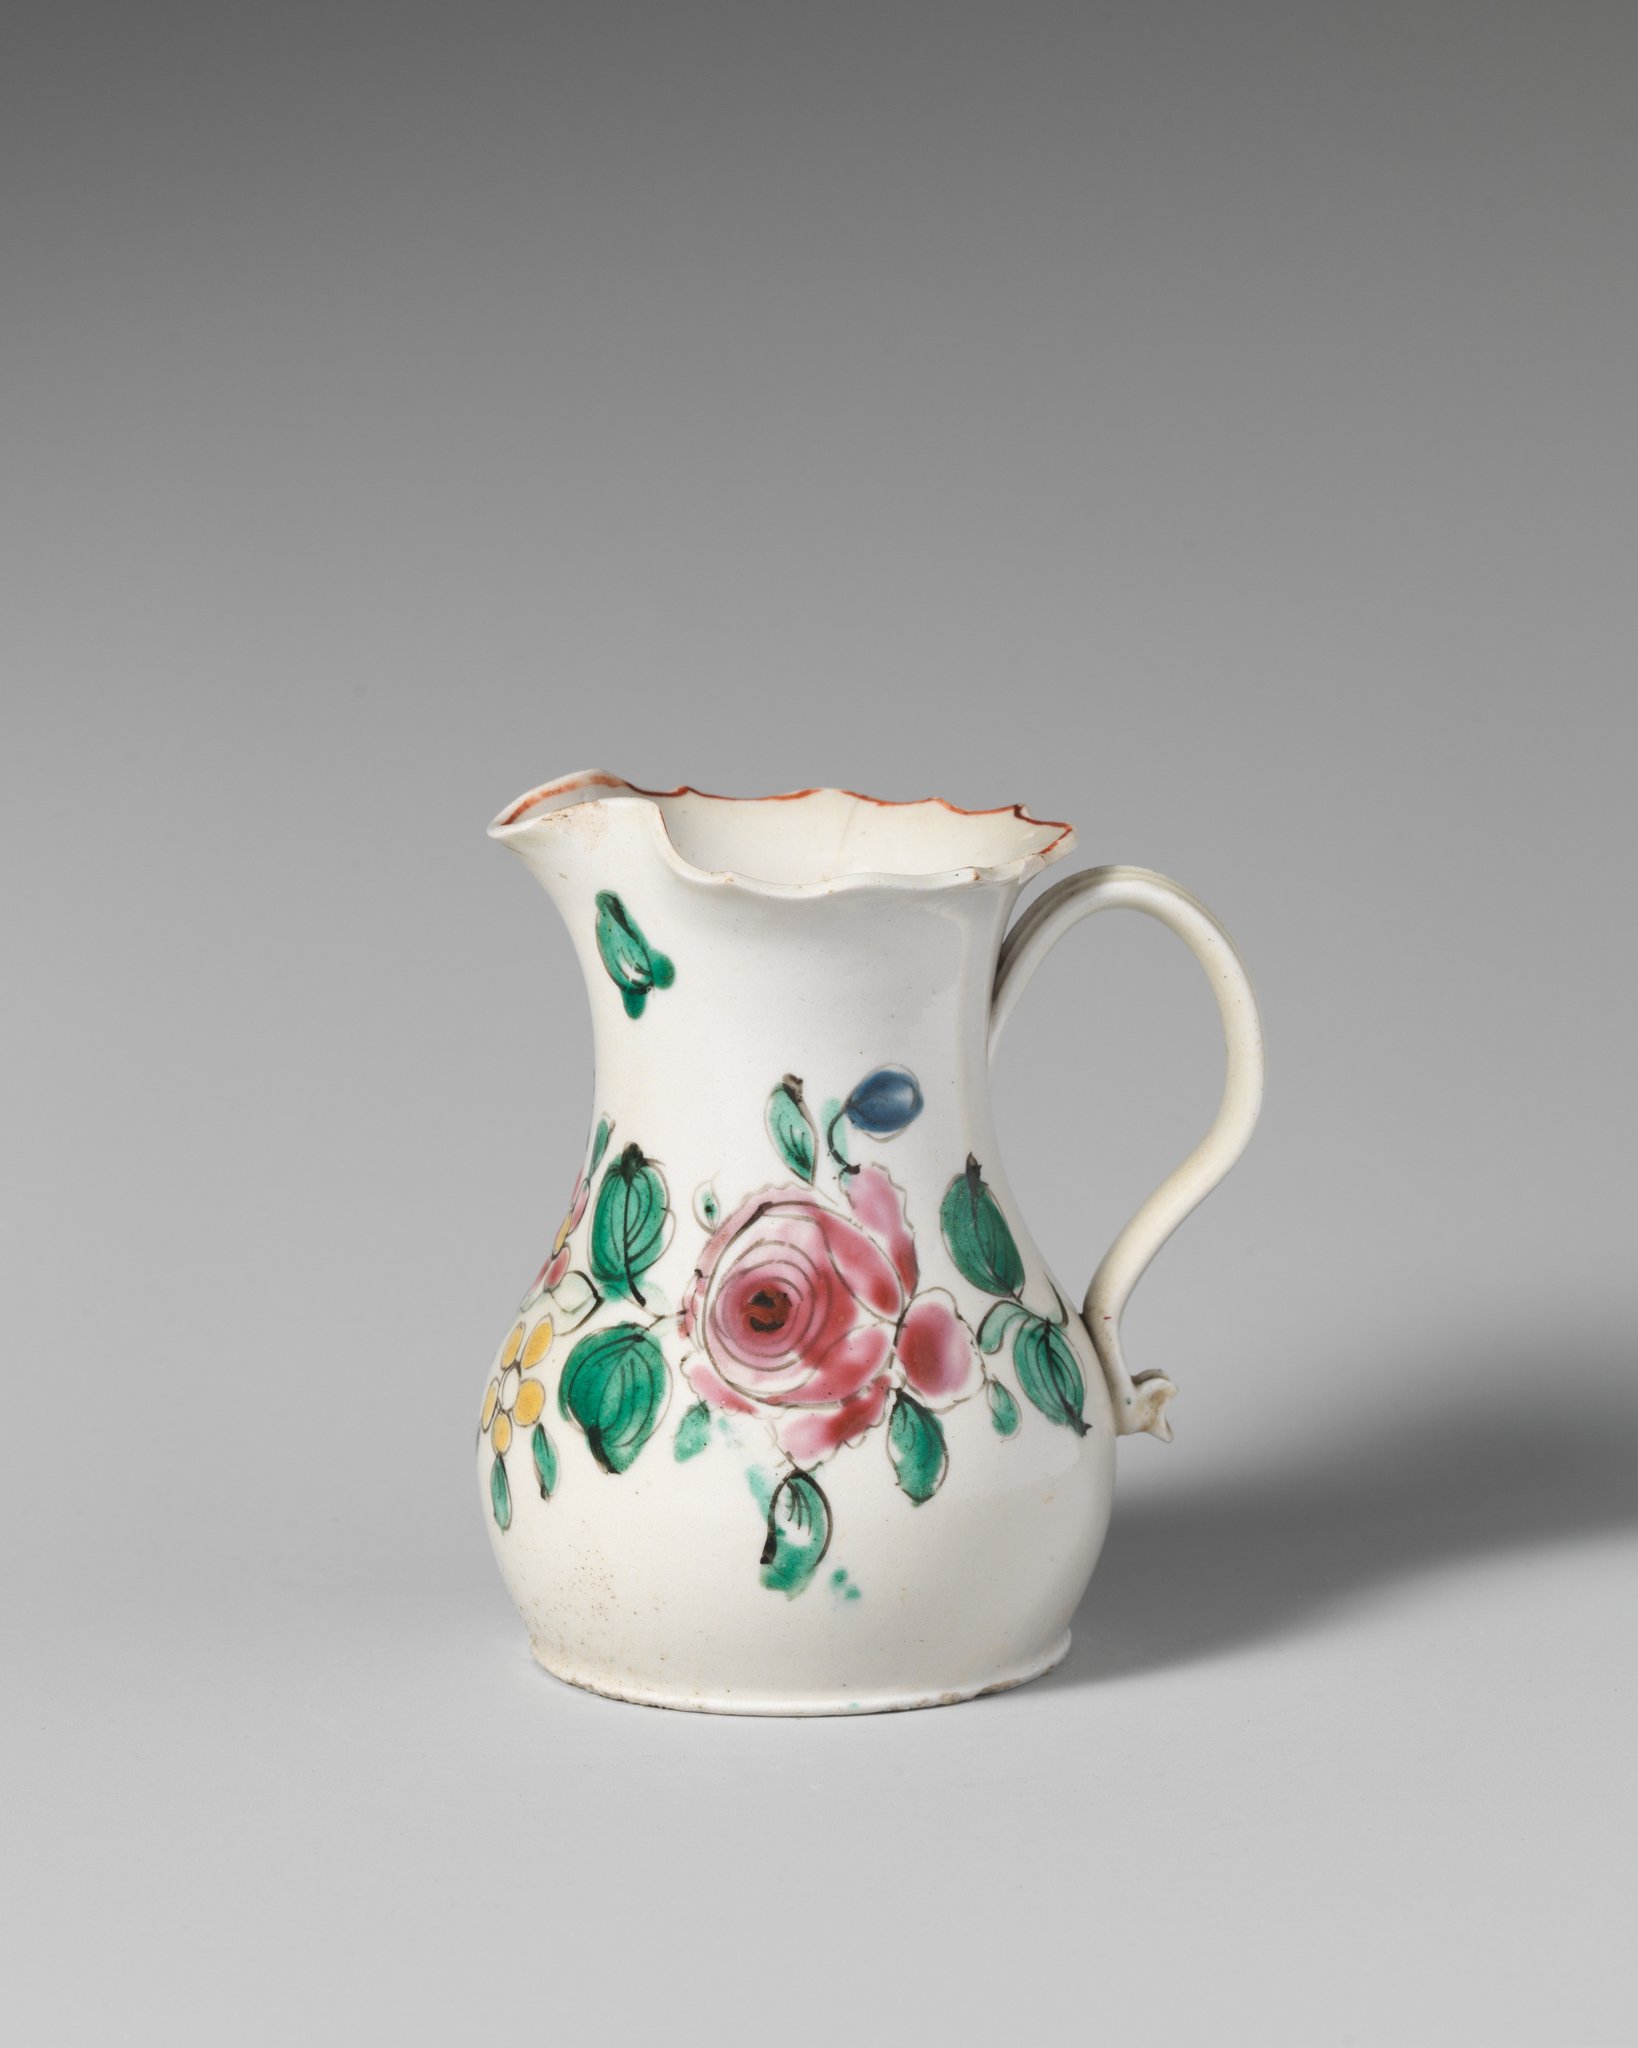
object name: cream jug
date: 1760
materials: stoneware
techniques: salt glaze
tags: roses